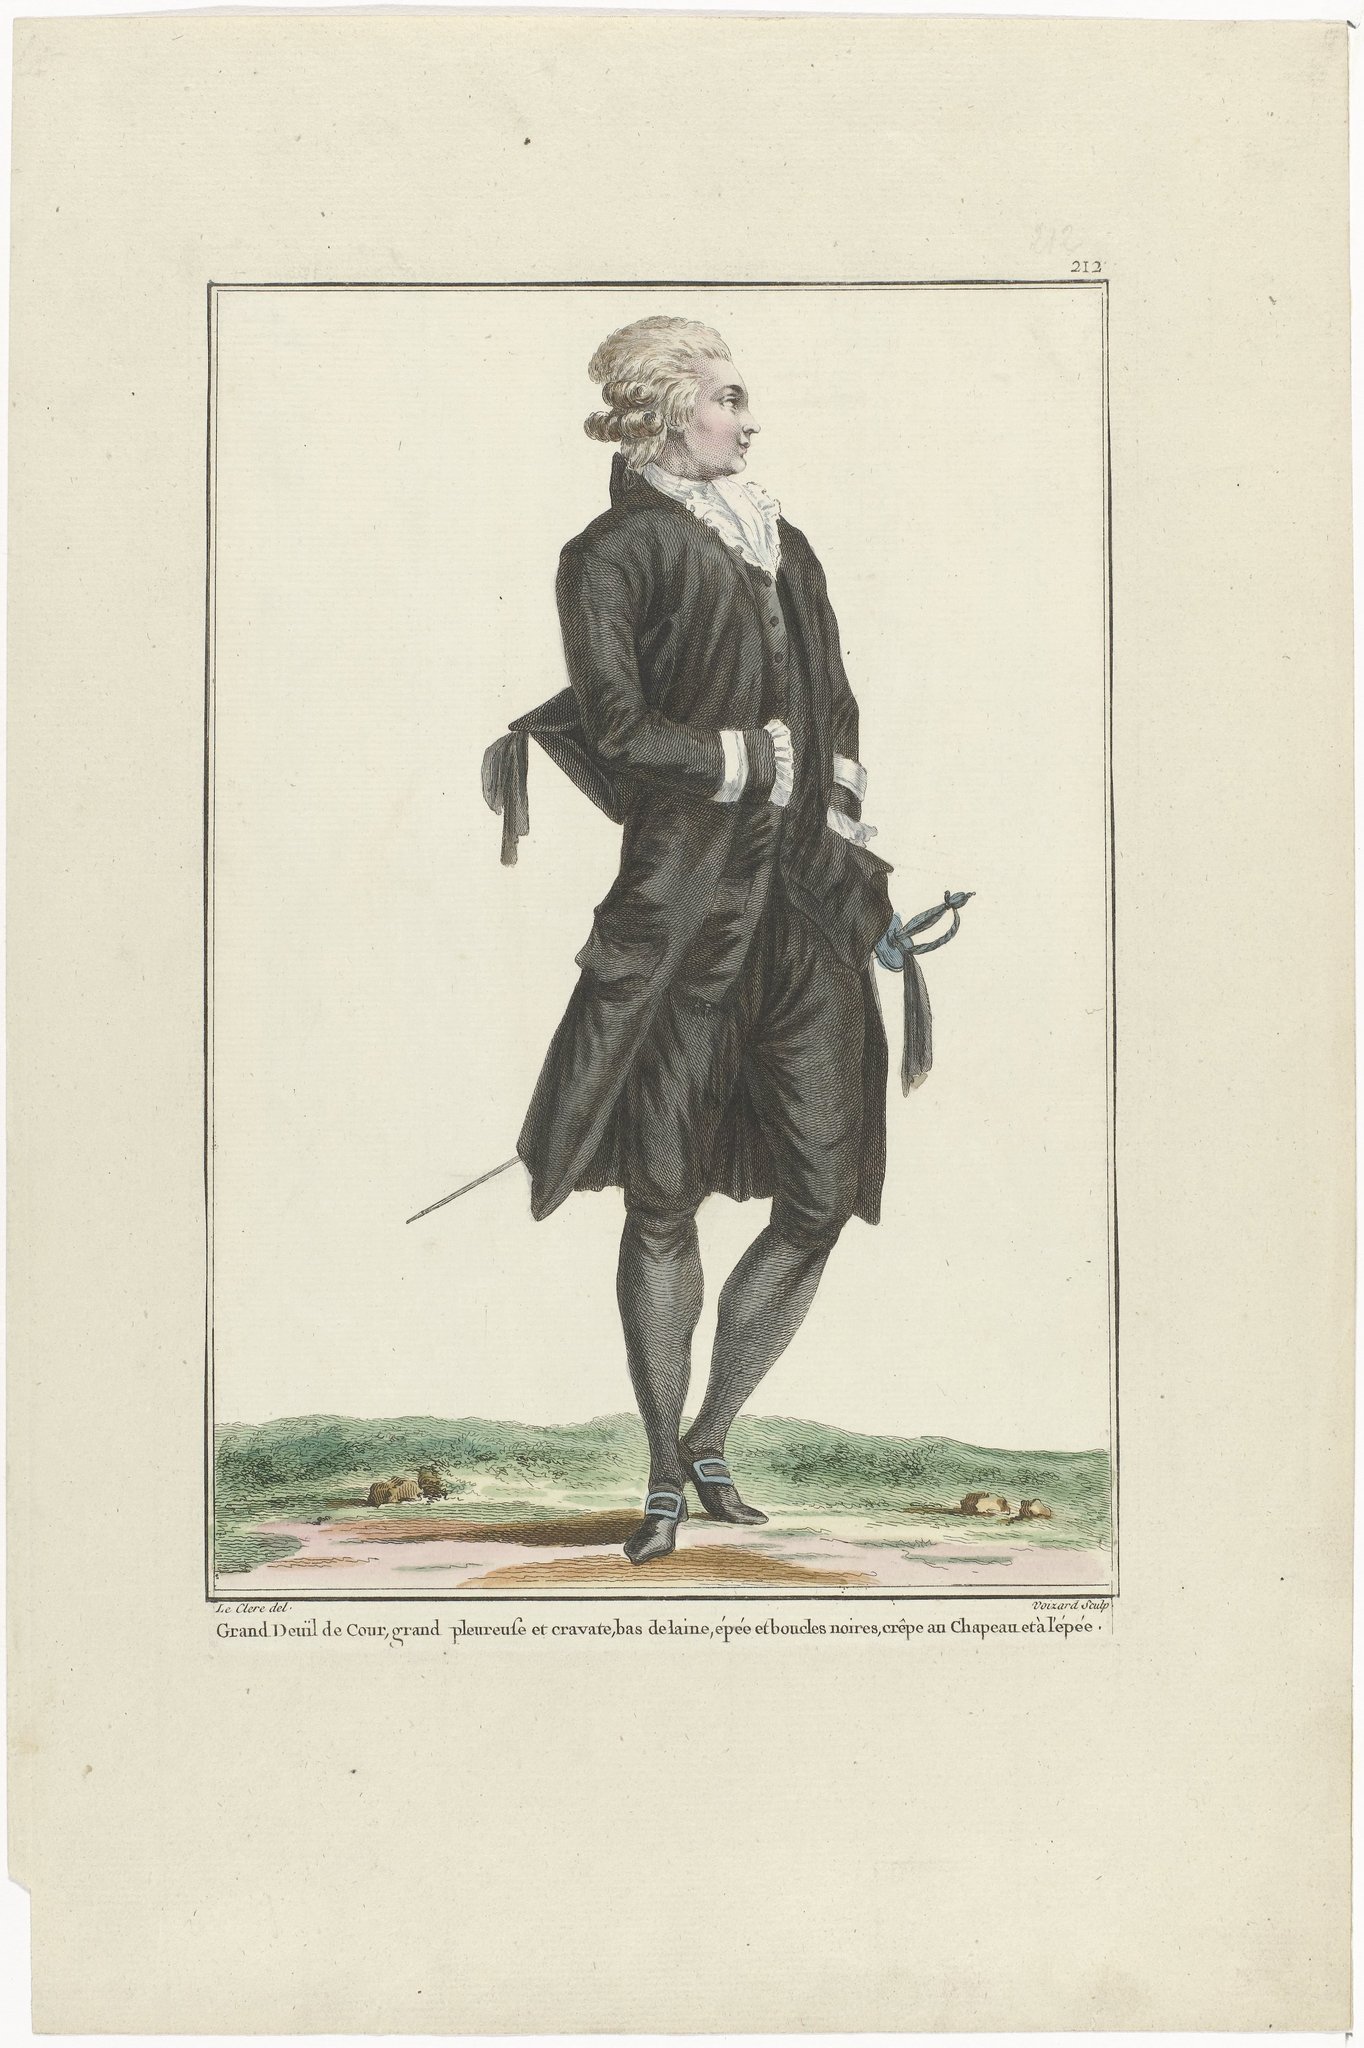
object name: fashion print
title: Gallerie des Modes et Costumes Français, 1781, nn 212 : Grand Deuil de Cour (...)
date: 1781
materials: paper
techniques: engraving, hand coloring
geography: paris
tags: head-gear: tricorn (+ men's clothes), clothing for the upper part of the body (vest) (+ men's clothes), neck-gear ~ clothing (cravat) (+ men's clothes), hacking and thrusting weapons, fashion plates, shoes, sandals (+ men's clothes), clothes, costume (+ men's clothes), mourning dress, trousers, breeches, etc. (breeches) (+ men's clothes), stockings, socks (+ men's clothes)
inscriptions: caption: ‘Grand Deuil de Cour, grand pleureuse et cravate, bas de laine, épée et voucles noires, crêpe an Chapeau et à l'épée.’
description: Man in zwart kostuum voor 'diepe rouw' aan het Franse hof. Het bestaat uit een frak, vest en kniebroek. Cravate, gerimpeld jabot en manchetten. Kousen van wol. Onder de arm een driekantige steek met rouwband van crêpe. Aan zijn linkerzijde een degen met rouwband van crêpe. Schoenen met vierkante gesp. Prent uit de serie nn. 37e Cahier des Costumes Français, 29e Suite d'Habillements à la mode en 1781, Gallerie des Modes et Costumes Français.